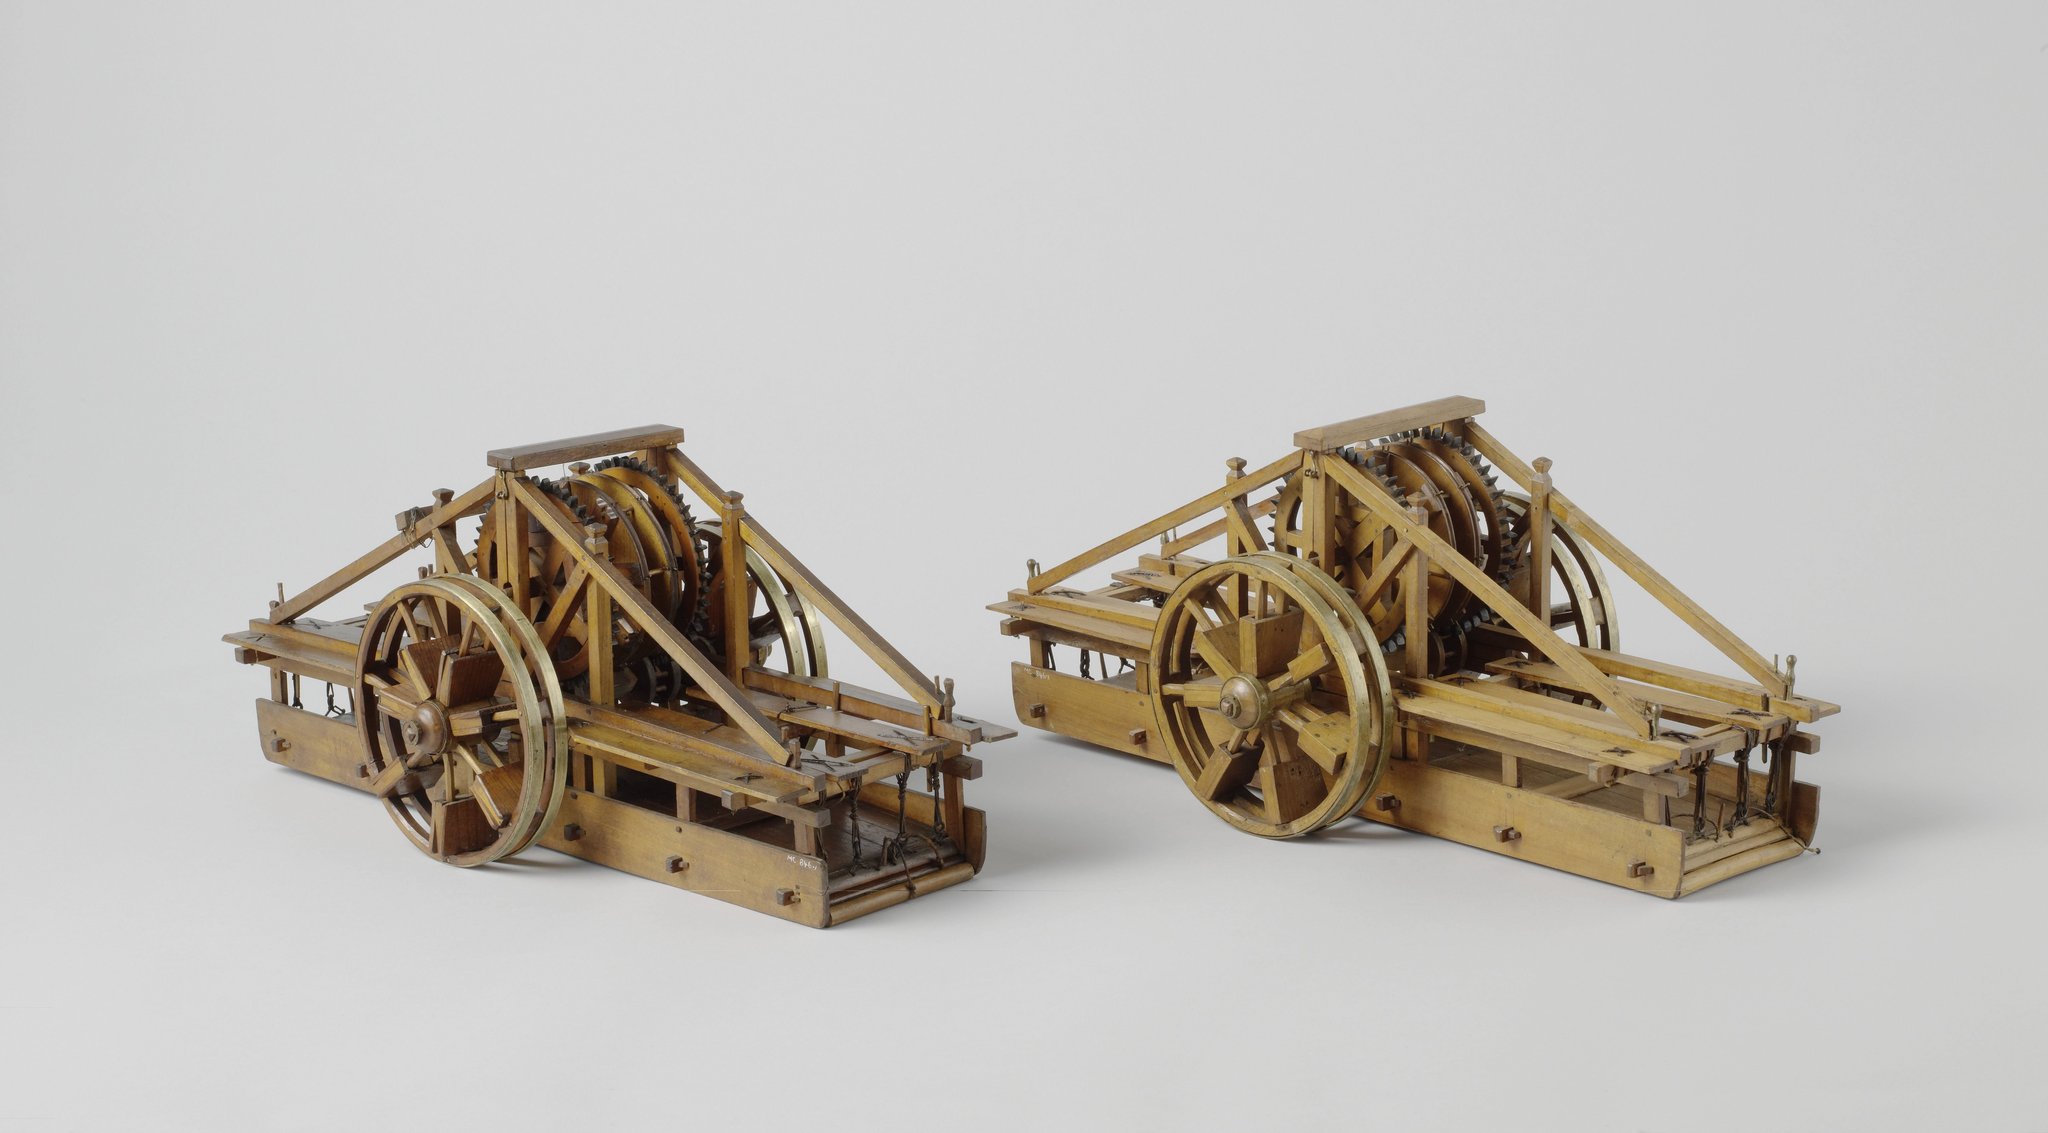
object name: demonstration model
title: Two Models of a Lifesaving Cart for Shipwrecks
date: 1832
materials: brass, fiber, wood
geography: rotterdam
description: Twee identieke modellen van een reddingstoestel voor reddingsoperaties bij schipbreuk op een strand. Het is een tweewielige wagen met de wielen in het midden; de wielen hebben zeven dubbele spaken, waaromheen schoepen zijn gemonteerd, die naar boven en beneden kunnen bewegen: deze inrichting dient waarschijnlijk om met behulp van het gewicht der telkens vallende schoepen de wenteling der wielen te bevorderen. De wielen worden aangedreven door een raderwerk in een houten raamwerk in het midden, dat een overbrenging heeft van 8/45 in tegengestelde richting.